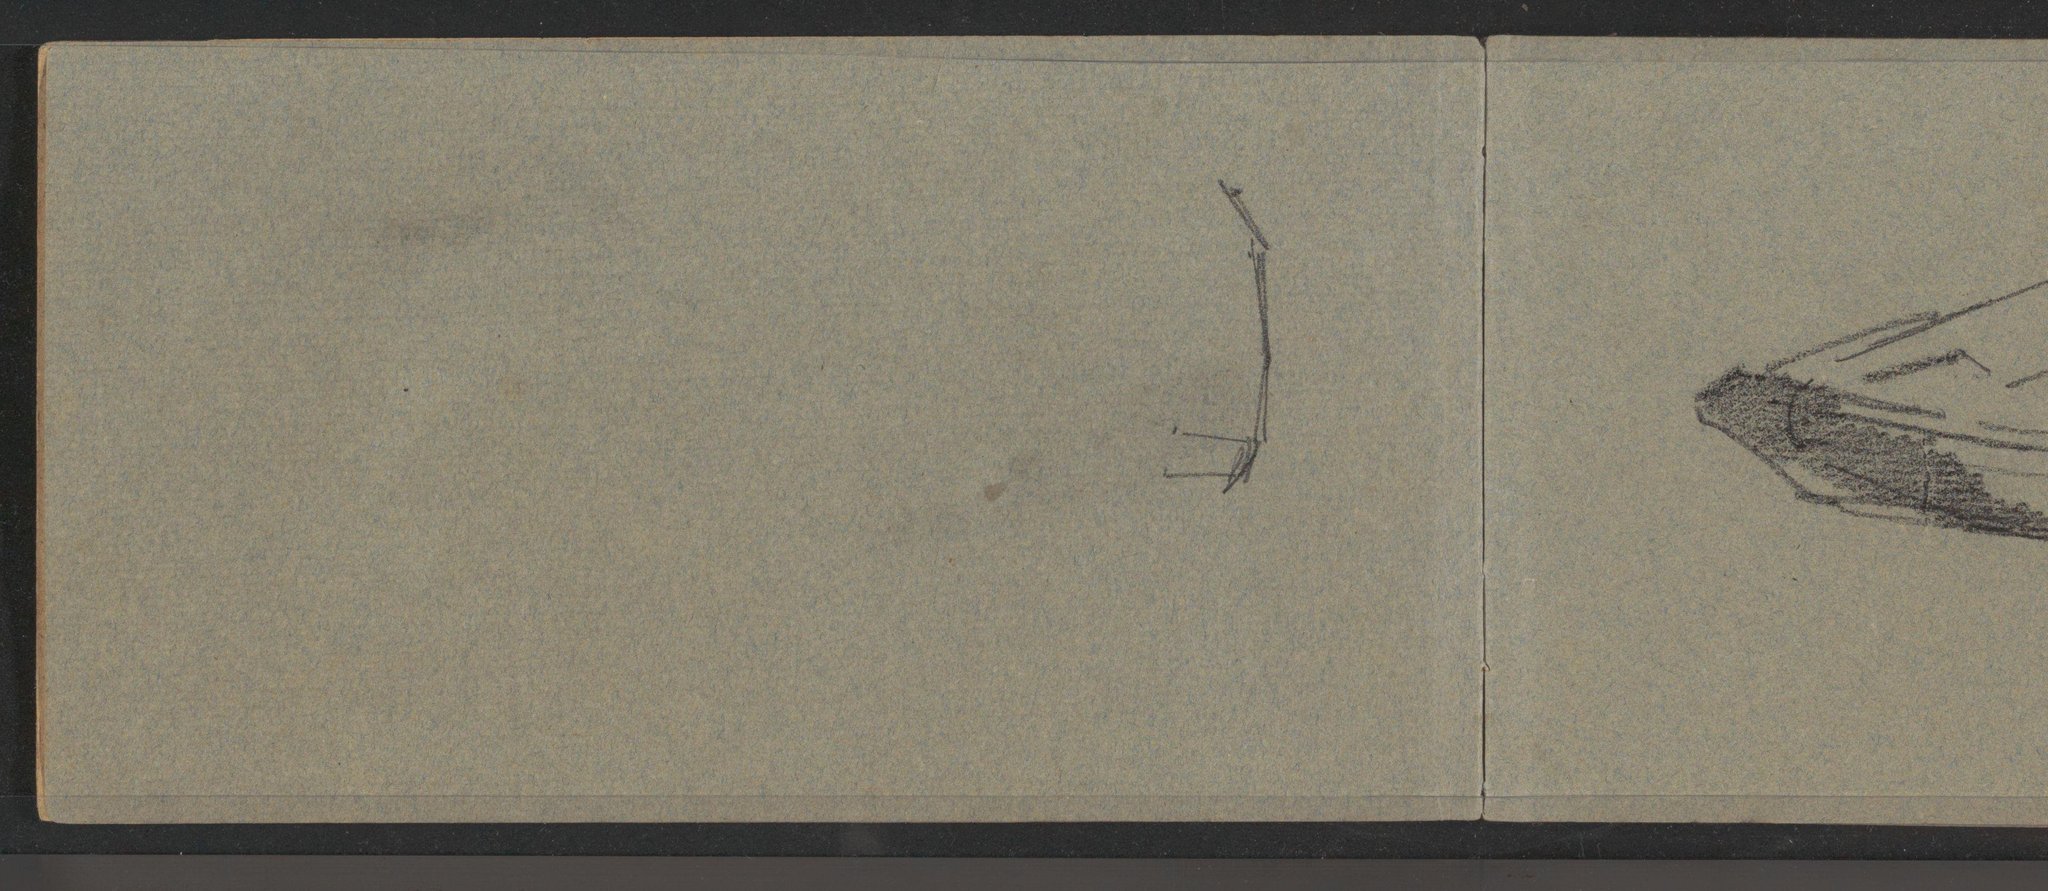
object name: sketchbook leaf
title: Studie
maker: george hendrik breitner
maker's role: draughtsman, painter, print maker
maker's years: 1857-1923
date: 1883-1885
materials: paper, pencil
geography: the hague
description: Blad 1 verso uit een schetsboek met 36 bladen.